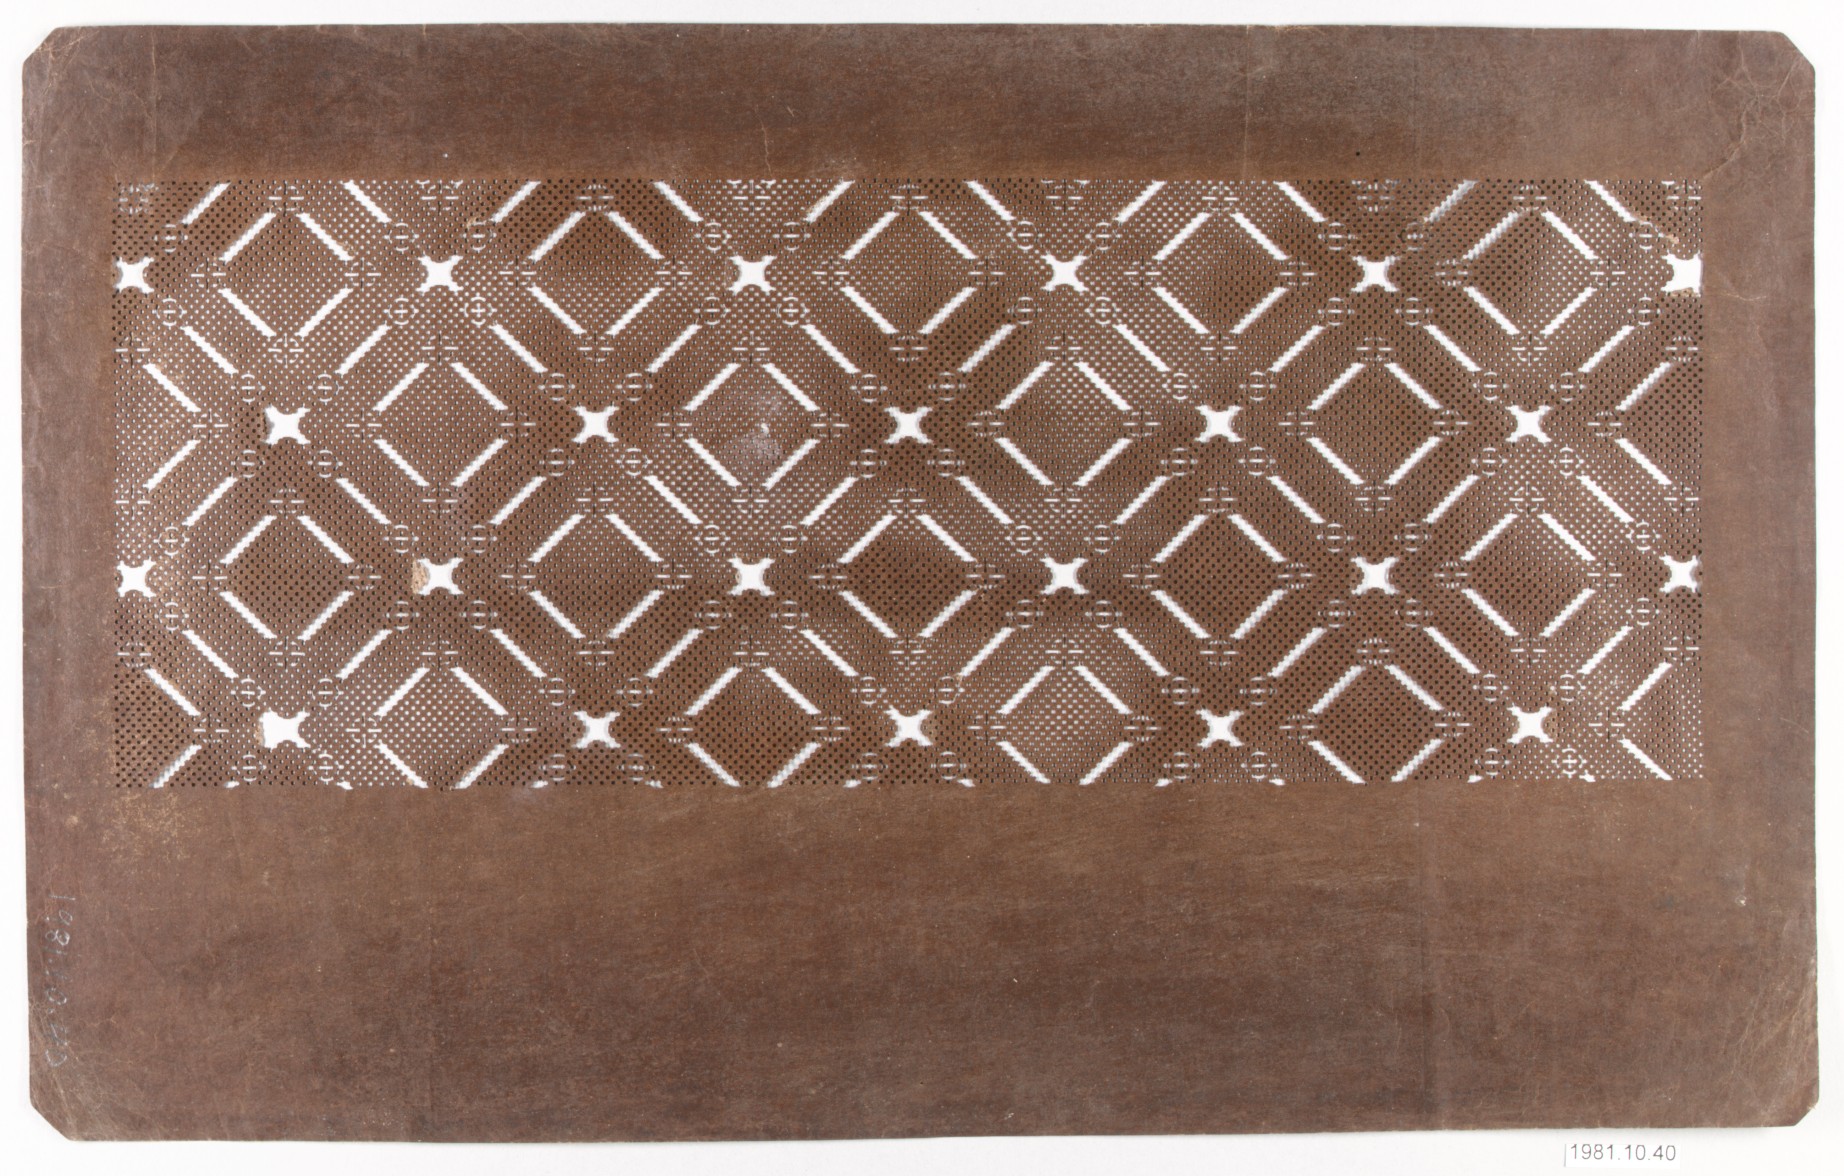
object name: stencil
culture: japanese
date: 1801-1900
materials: paper